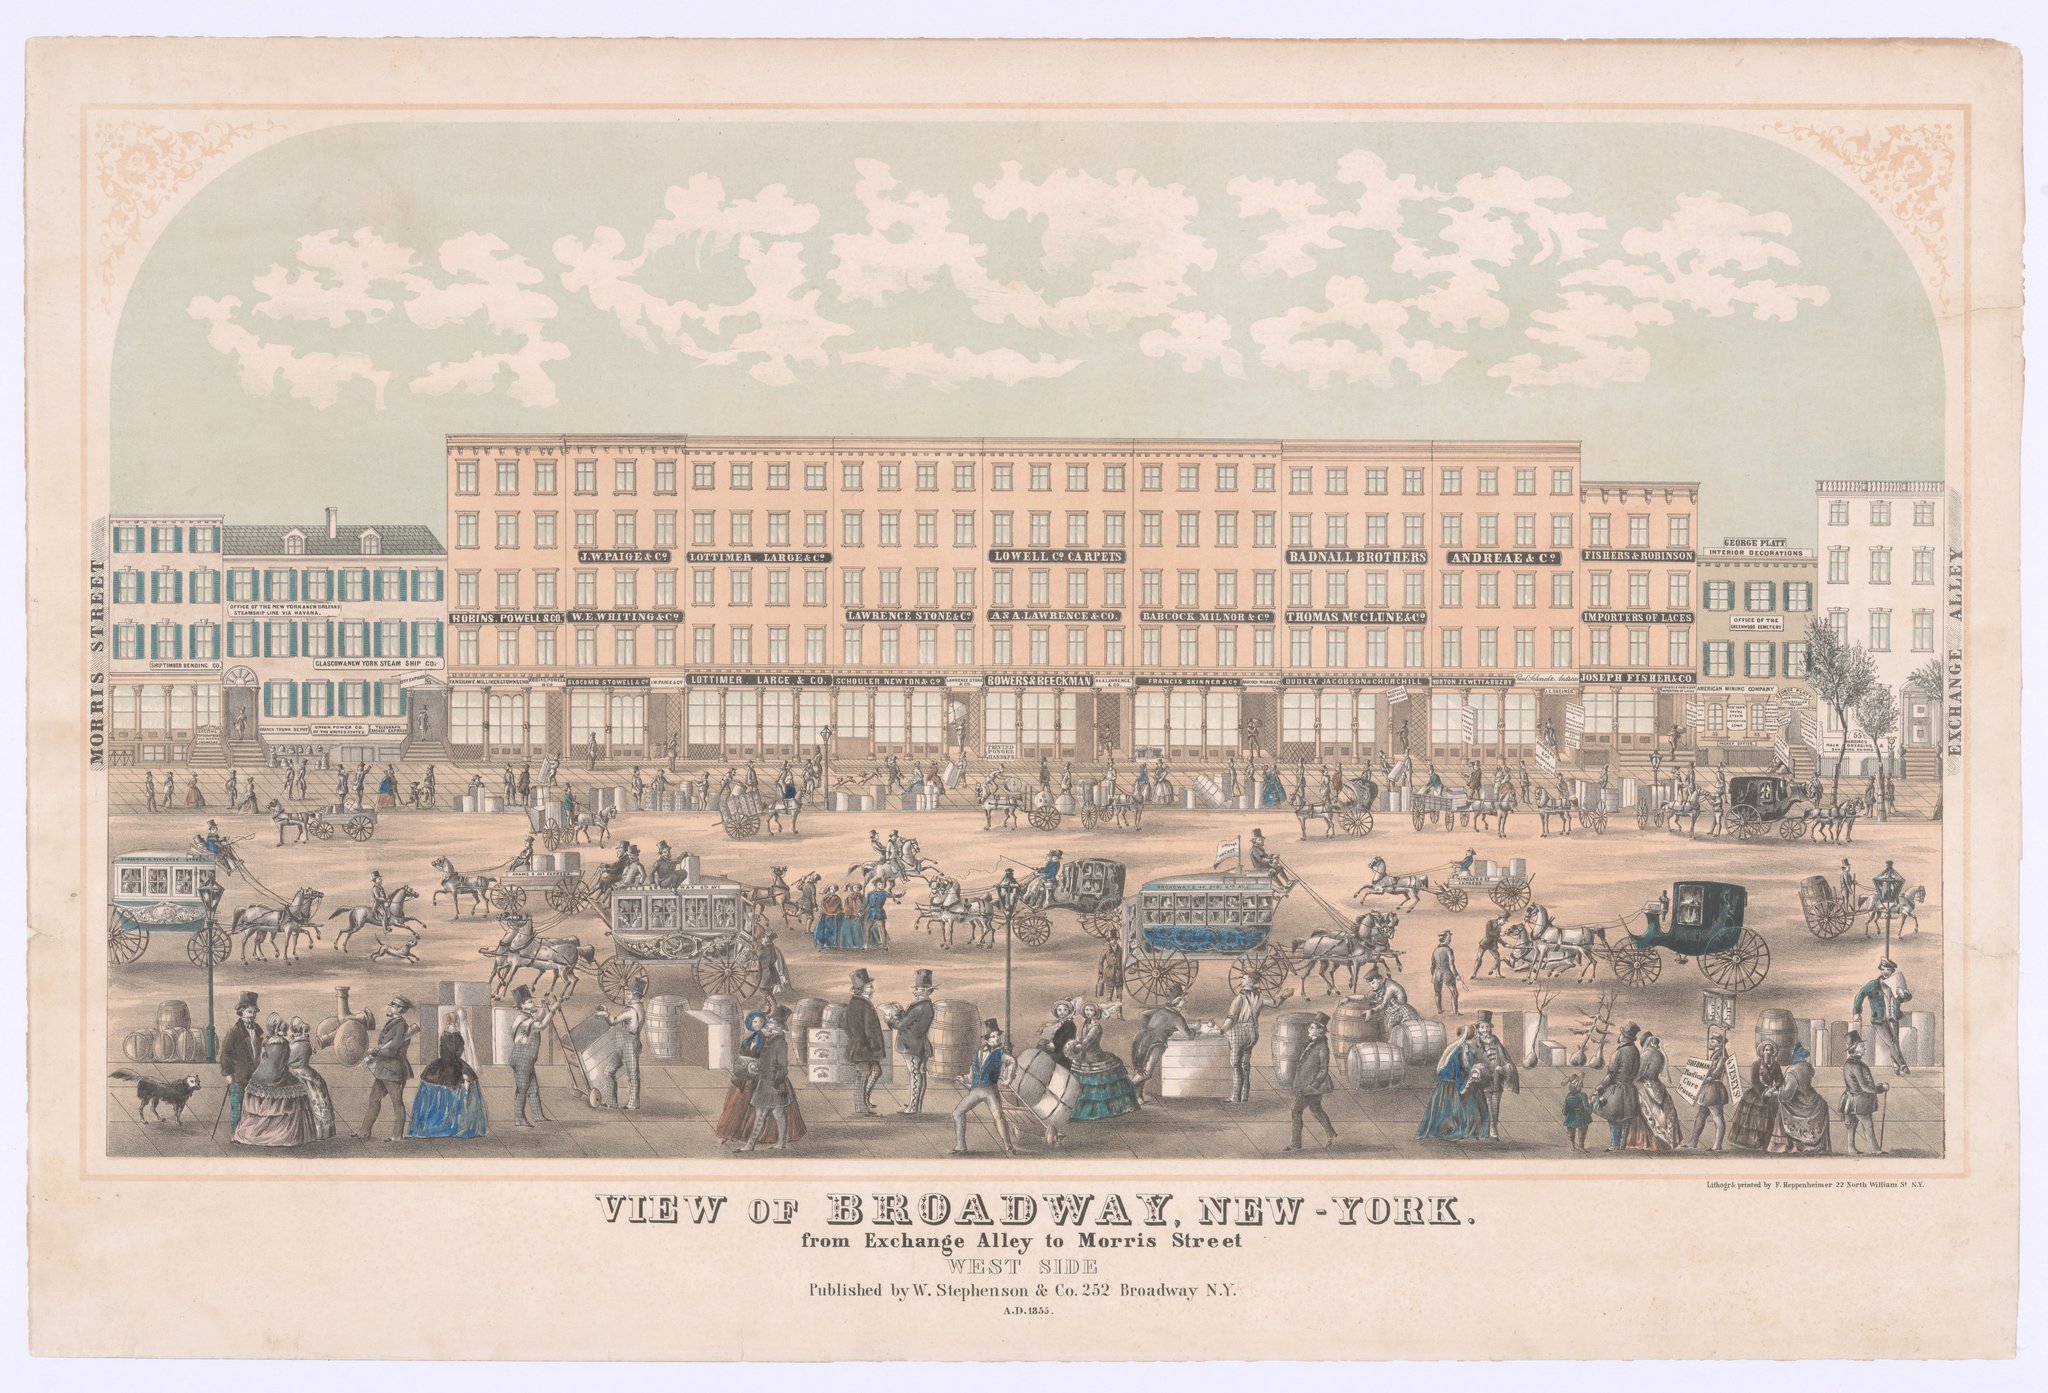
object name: print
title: View of Broadway, New-York, from Exchange Alley to Morris Street, West Side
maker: frederick heppenheimer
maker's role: lithographer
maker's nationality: american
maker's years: 1826-1878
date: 1855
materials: stone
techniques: hand coloring, lithograph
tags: buildings,cities,streets,carriages,new york city